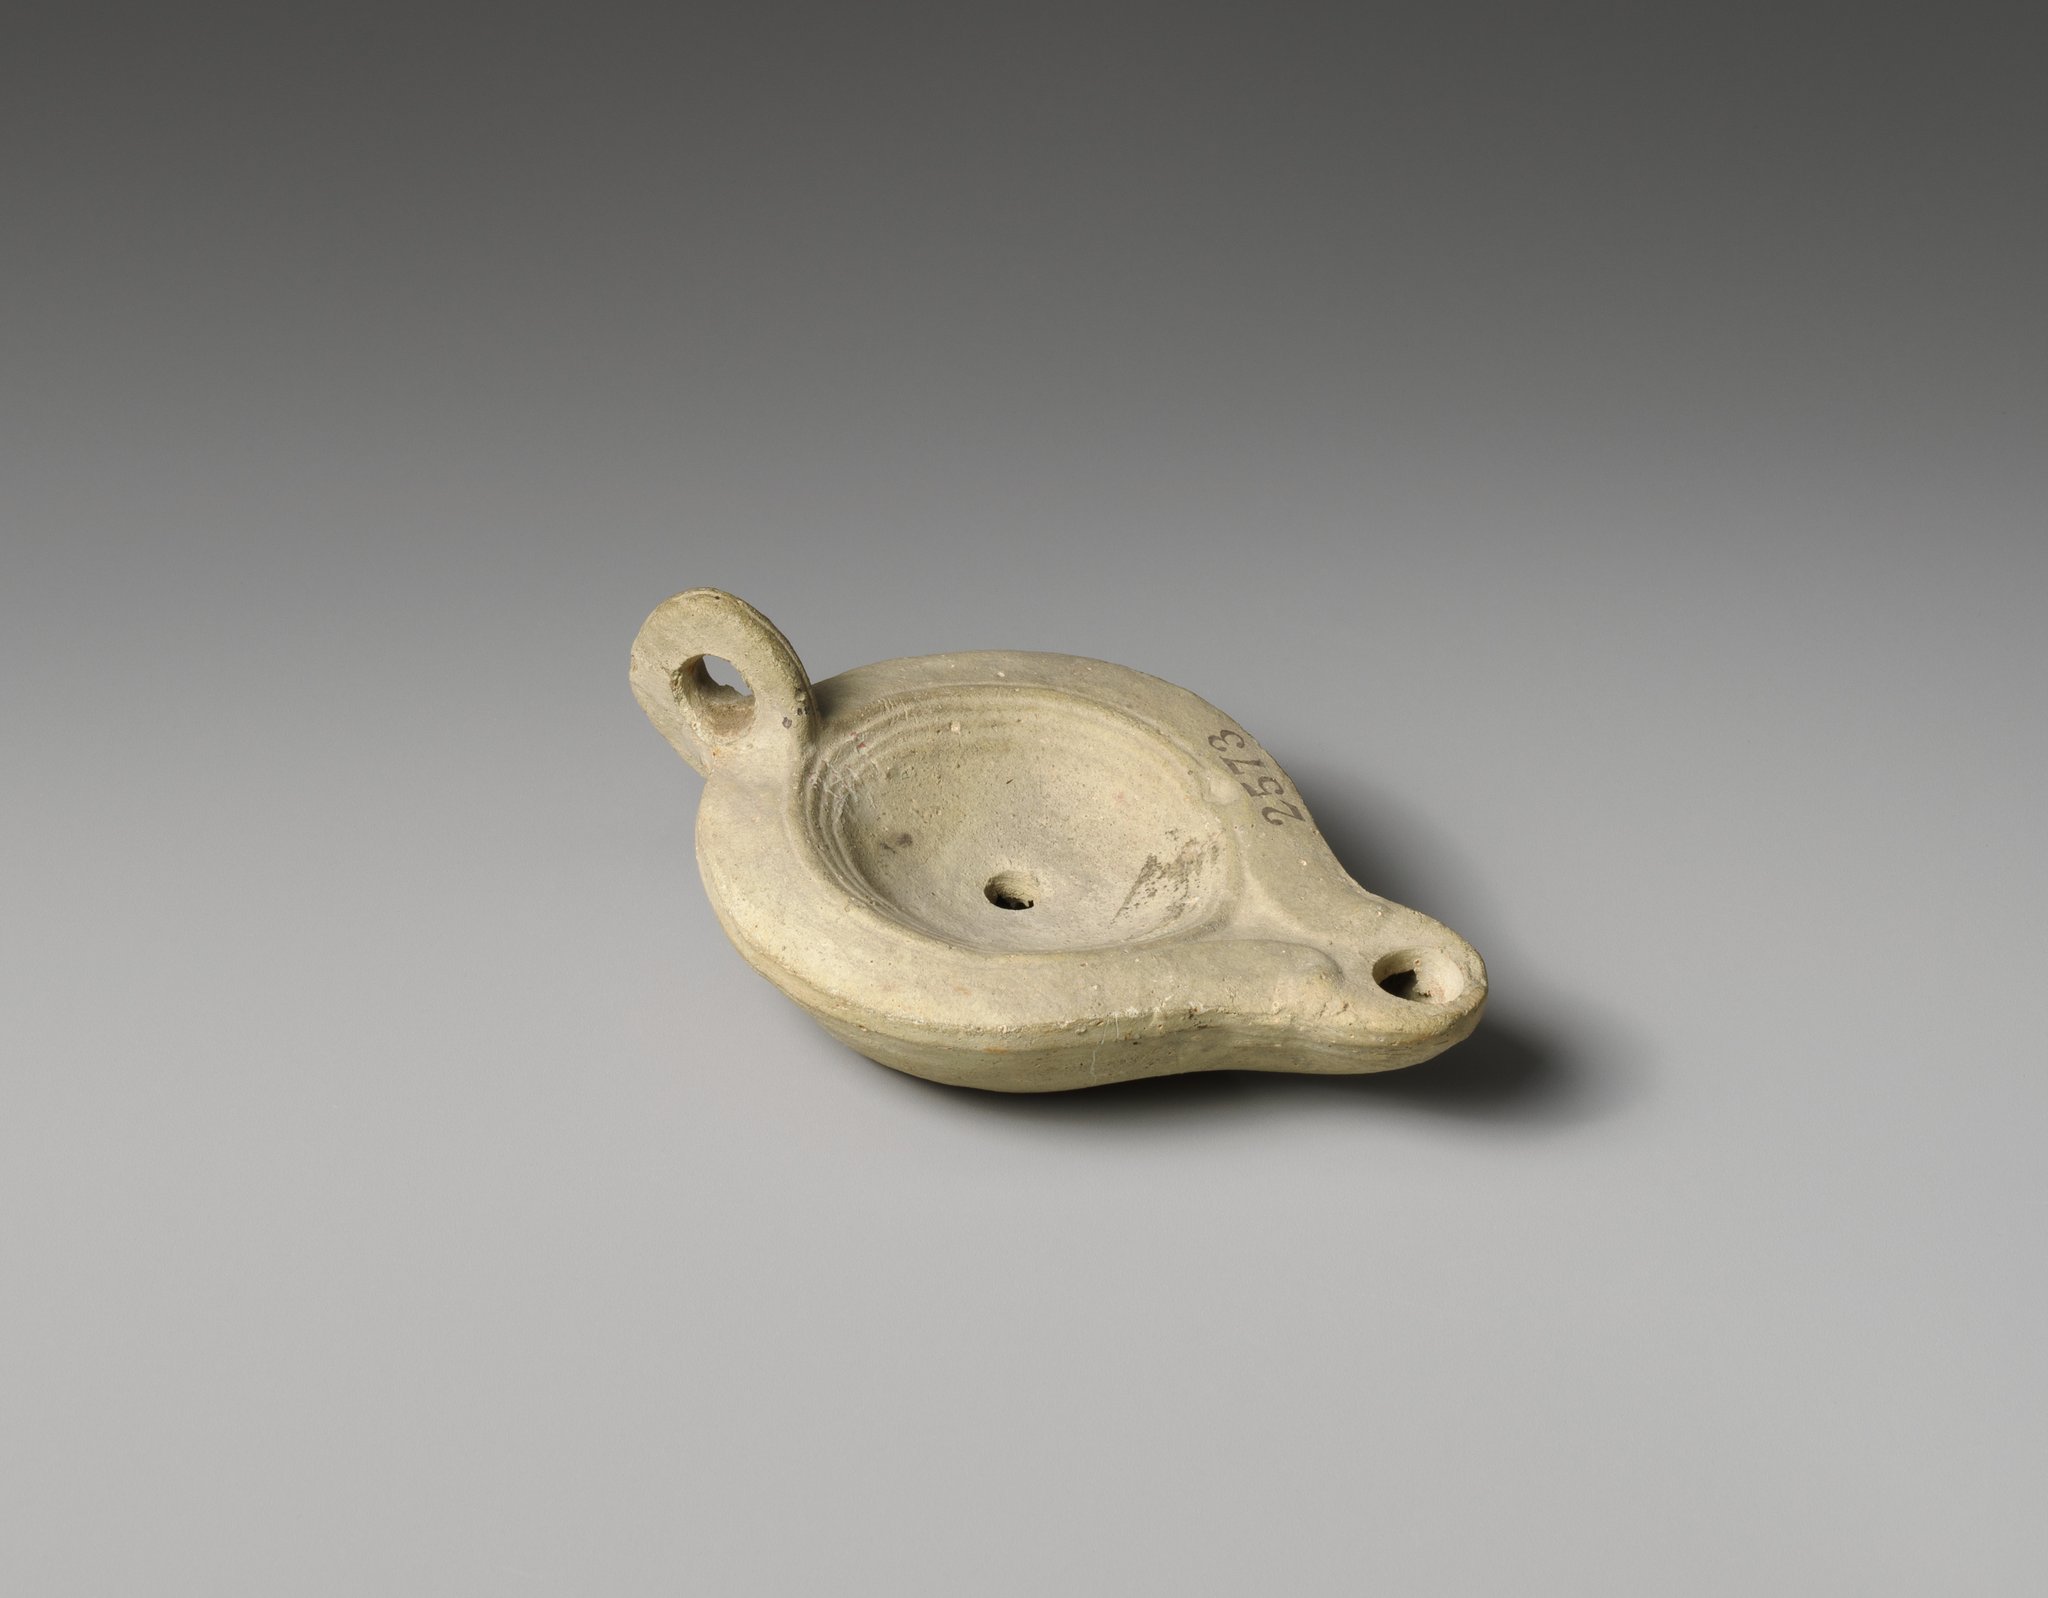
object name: lamp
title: Terracotta oil lamp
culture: roman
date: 90-150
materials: terracotta